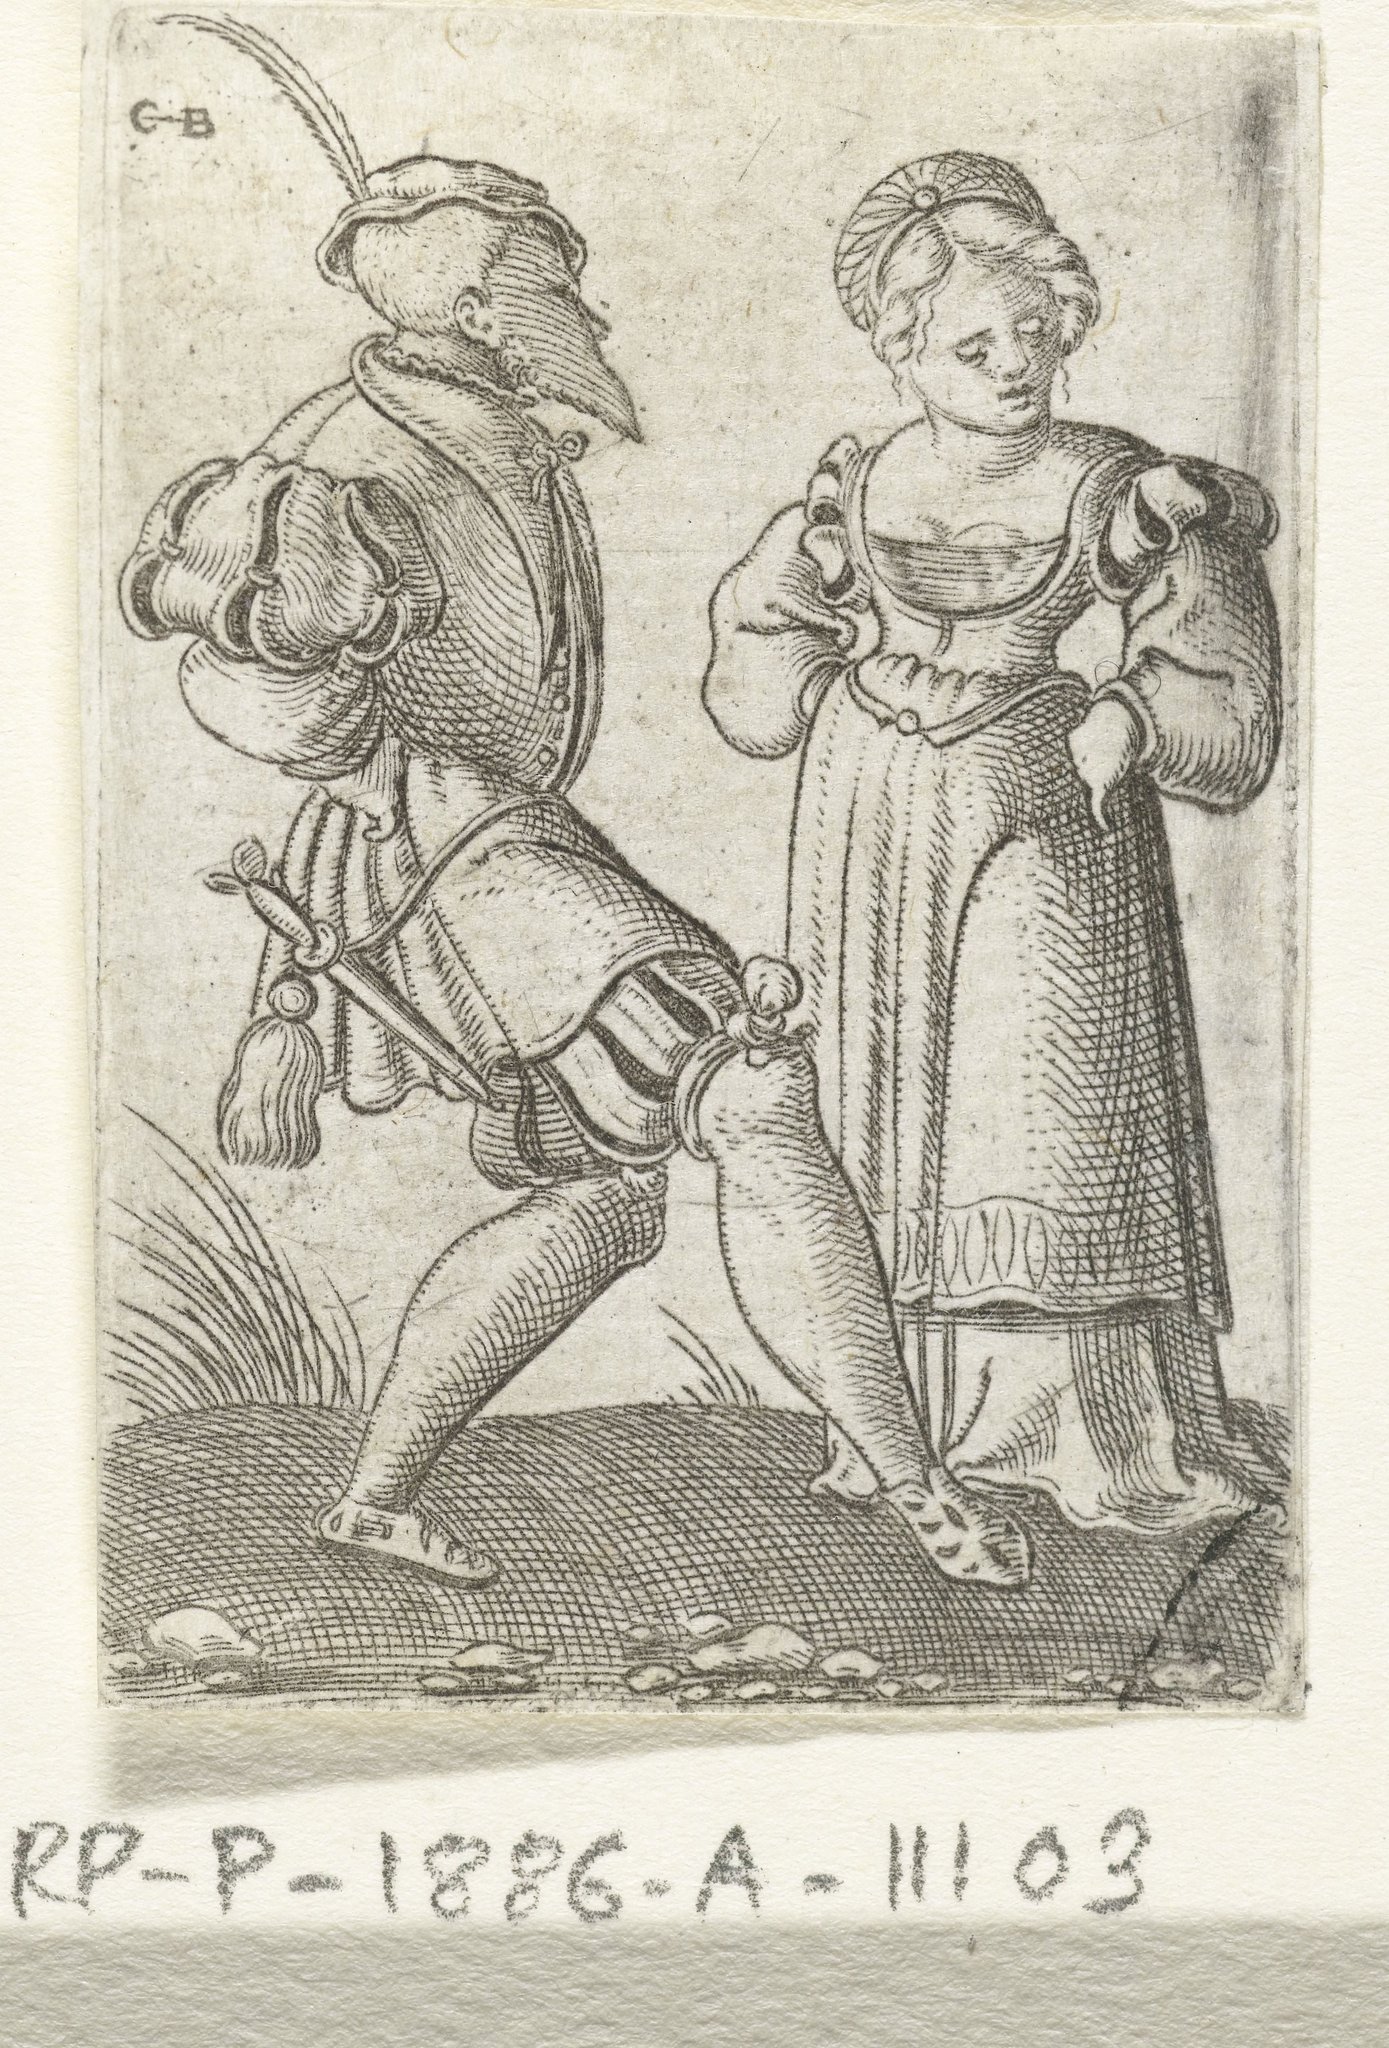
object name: print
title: Dansend stel, de man draagt een hoed met een lange veer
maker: cornelis bos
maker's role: print maker, printer, publisher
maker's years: 1510-1566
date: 1546-1548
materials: paper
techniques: engraving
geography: nuremberg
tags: dancing at wedding feast - dd - out of doors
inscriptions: collector's mark: Lugt 2228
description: Prent uit een serie van 12 prenten met dansende stellen in de buitenlucht.